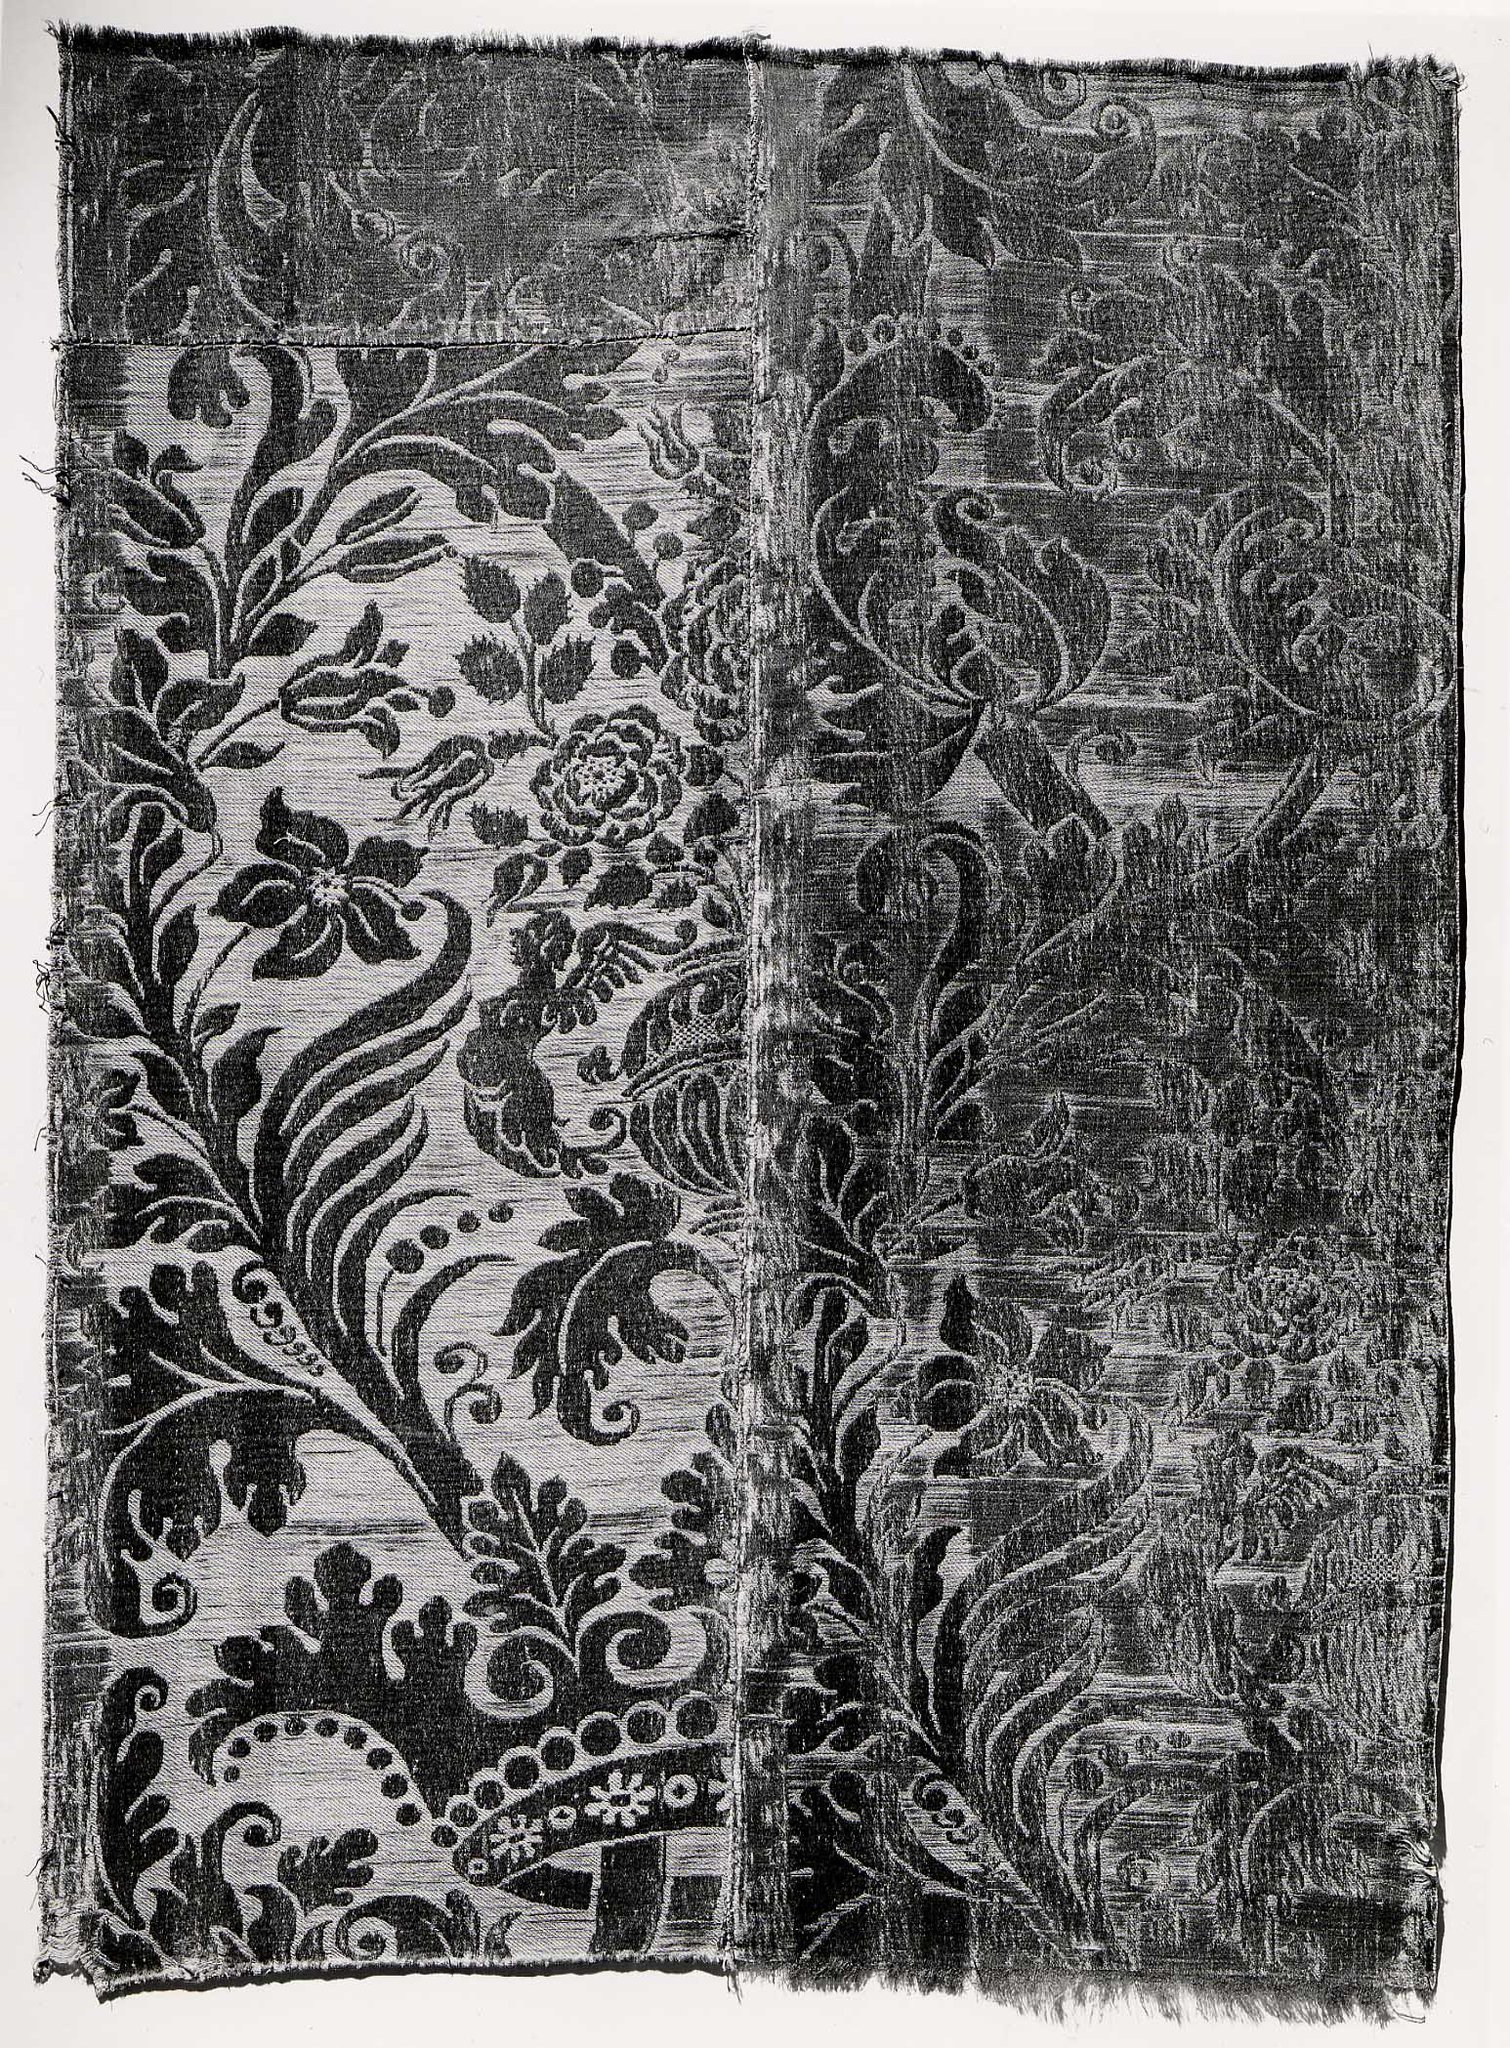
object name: textile panel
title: Panel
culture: italian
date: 1651-1700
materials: linen, silk